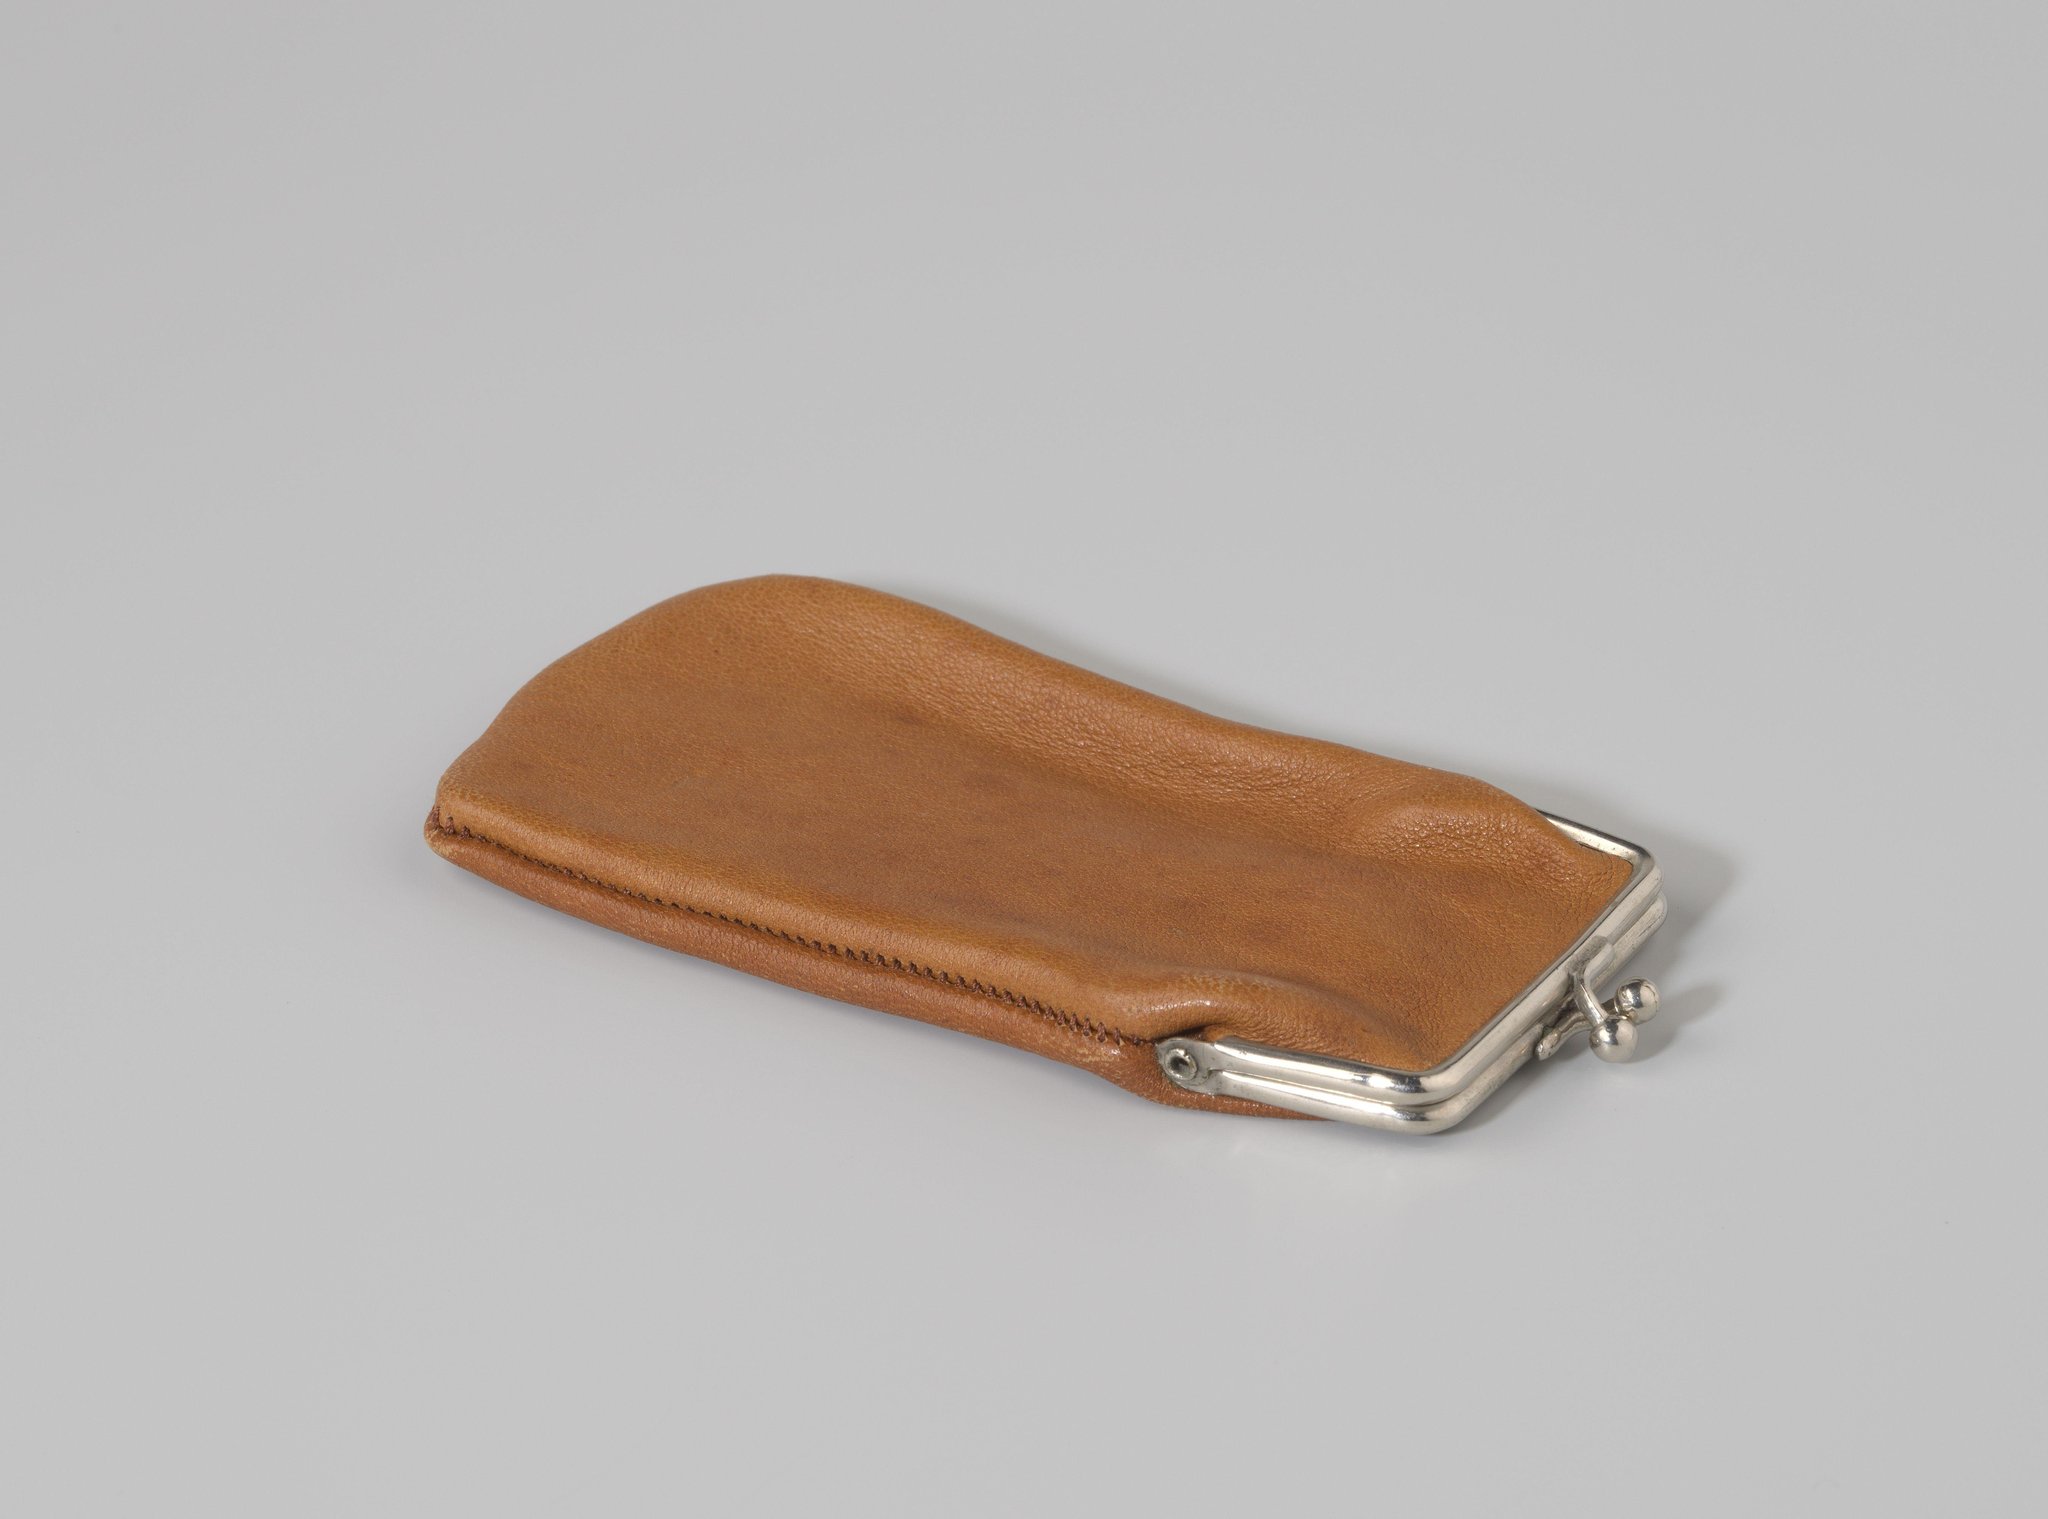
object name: étui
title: Euit van bruin leer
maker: Anonymous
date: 1900-1925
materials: leather, metal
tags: eugen wachenheimer, else wachenheimer-moos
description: Dit object is onderdeel van de nalatenschap van Isabel Elon-Wachenheimer (1928-2010). Tot haar overlijden behoorde het samen met de andere objecten uit de nalatenschap tot haar privédomein van Isabel Wachenheimer. In die particuliere context zijn deze objecten tezamen en individueel aandenkens - aan de jeugd, ouders en familie van Isabel Wachenheimer vóór en tijdens de Shoah en aan haar leven na de Tweede Wereldoorlog. Isabel Wachenheimer, die van juni 1943 tot mei 1945 gevangen zat in Kamp Westerbork, Theresienstadt, Auschwitz, Lenzing a/d Oberdonau (een buitenkamp van Mauthausen), overleefde de Shoah. Haar ouders – Eugène Wachenheimer en Else Wachenheimer-Moos - werden op 14 oktober 1944 in Auschwitz-Birkenau vermoord.